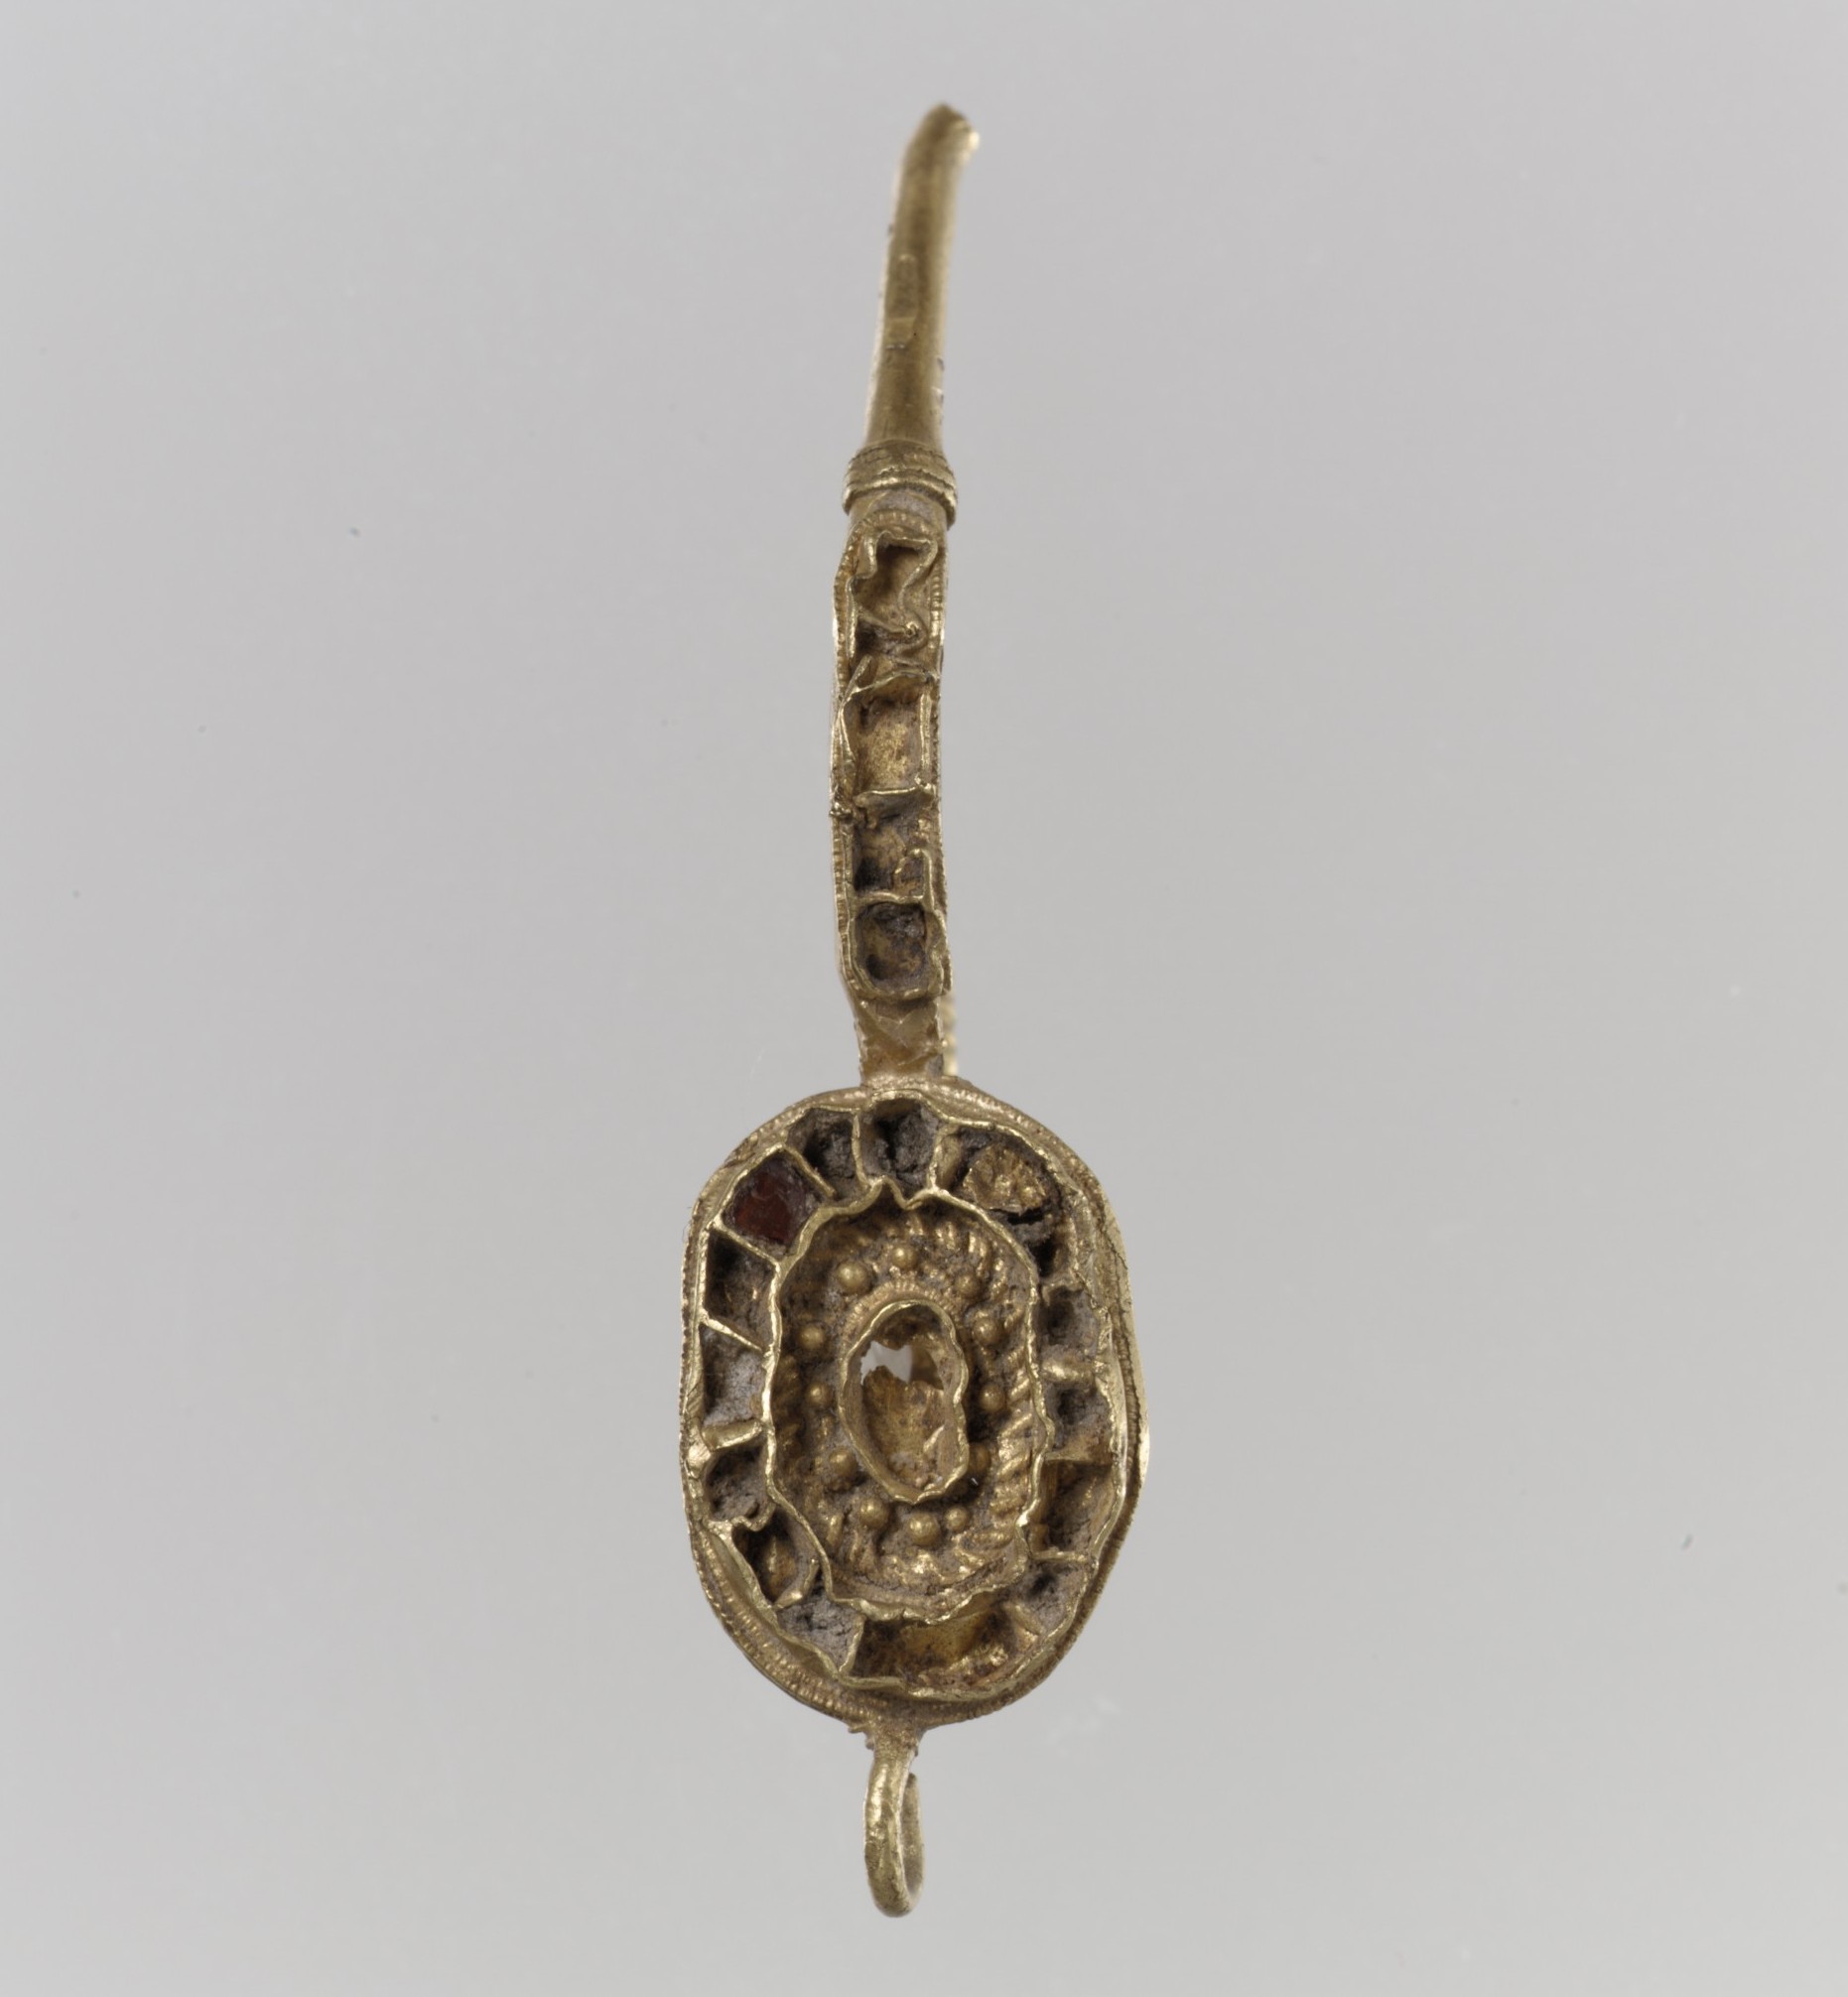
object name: earring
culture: byzantine or langobardic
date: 501-700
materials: garnet, gold